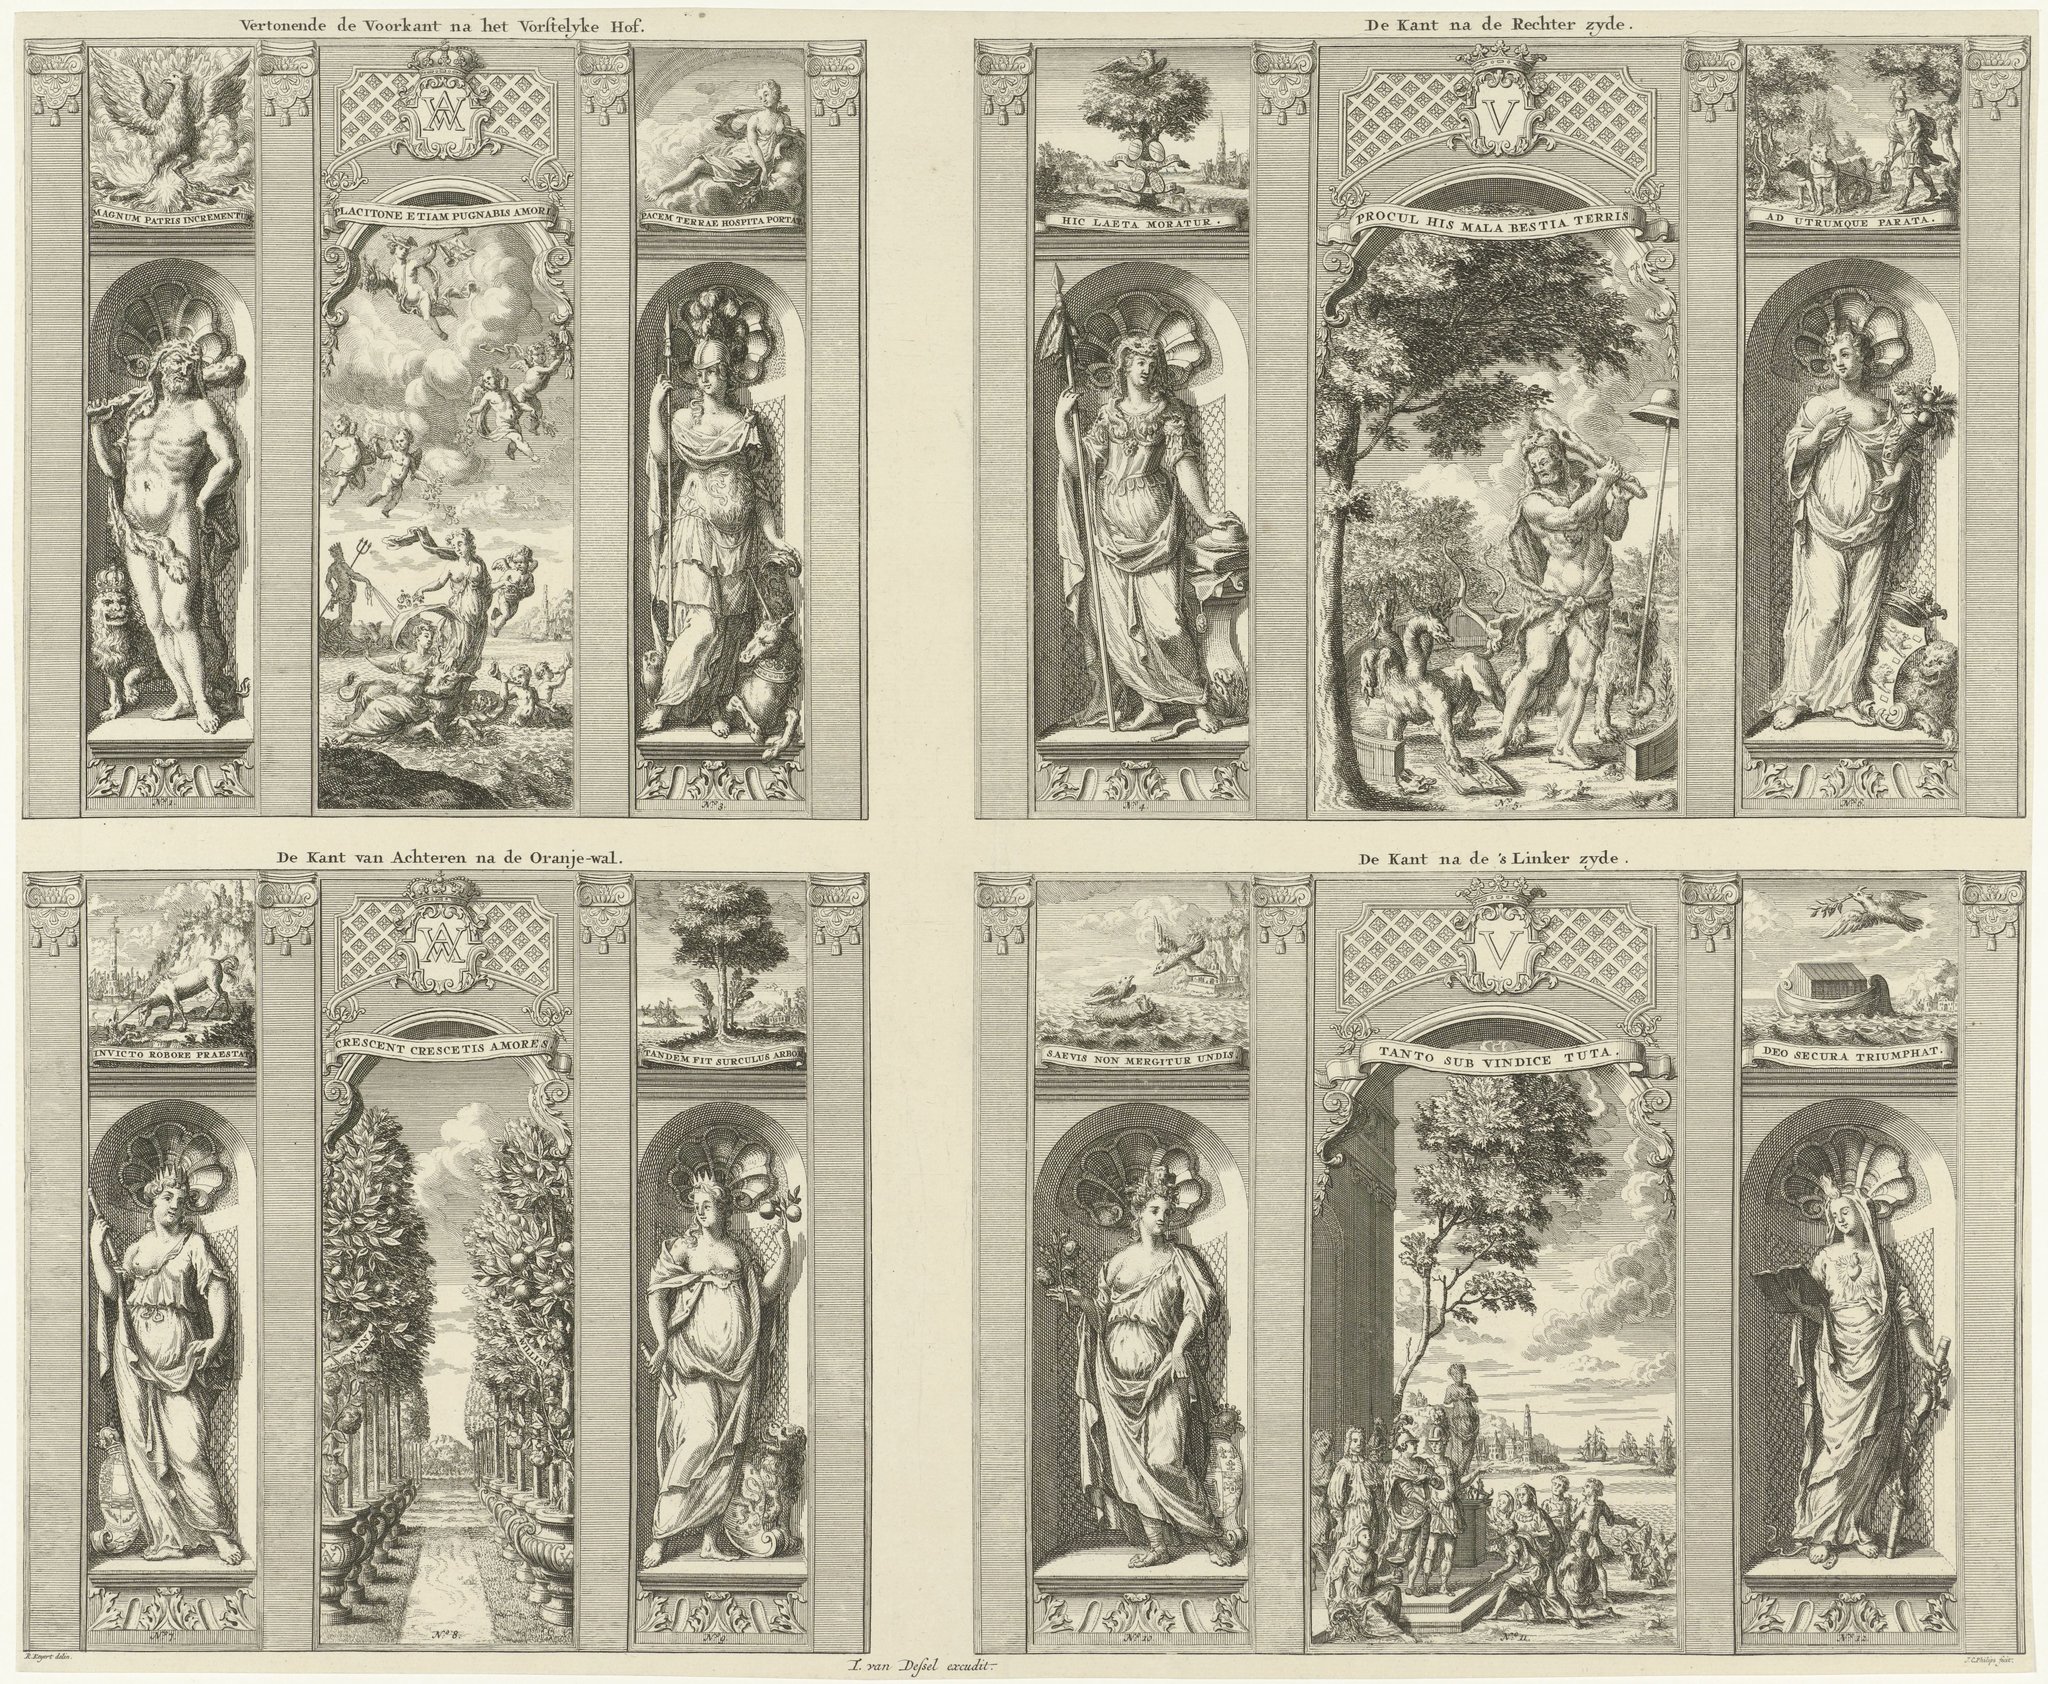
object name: print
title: De voorstellingen op de zijden van de tempel in het vuurwerk te Leeuwarden bij de inkomst van het pasgetrouwde paar prins Willem IV en Anna van Engeland, 1734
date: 1734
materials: paper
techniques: engraving, etching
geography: amsterdam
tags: willem iv (prins van oranje-nassau), anna van hannover, public festivities at marriage of royal persons (+ illumination, fire-works ~ festive activities)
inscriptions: collector's mark: Lugt 2228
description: De allegorische voorstellingen aangebracht op de vier zijden van de tempel in het vuurwerk aangericht te Leeuwarden op 11 mei 1734 ter gelegenheid van de inkomst van het pasgetrouwde paar prins Willem IV en prinses Anna, gehuwd op 25 maart 1734. De scènes genummerd 1-12.